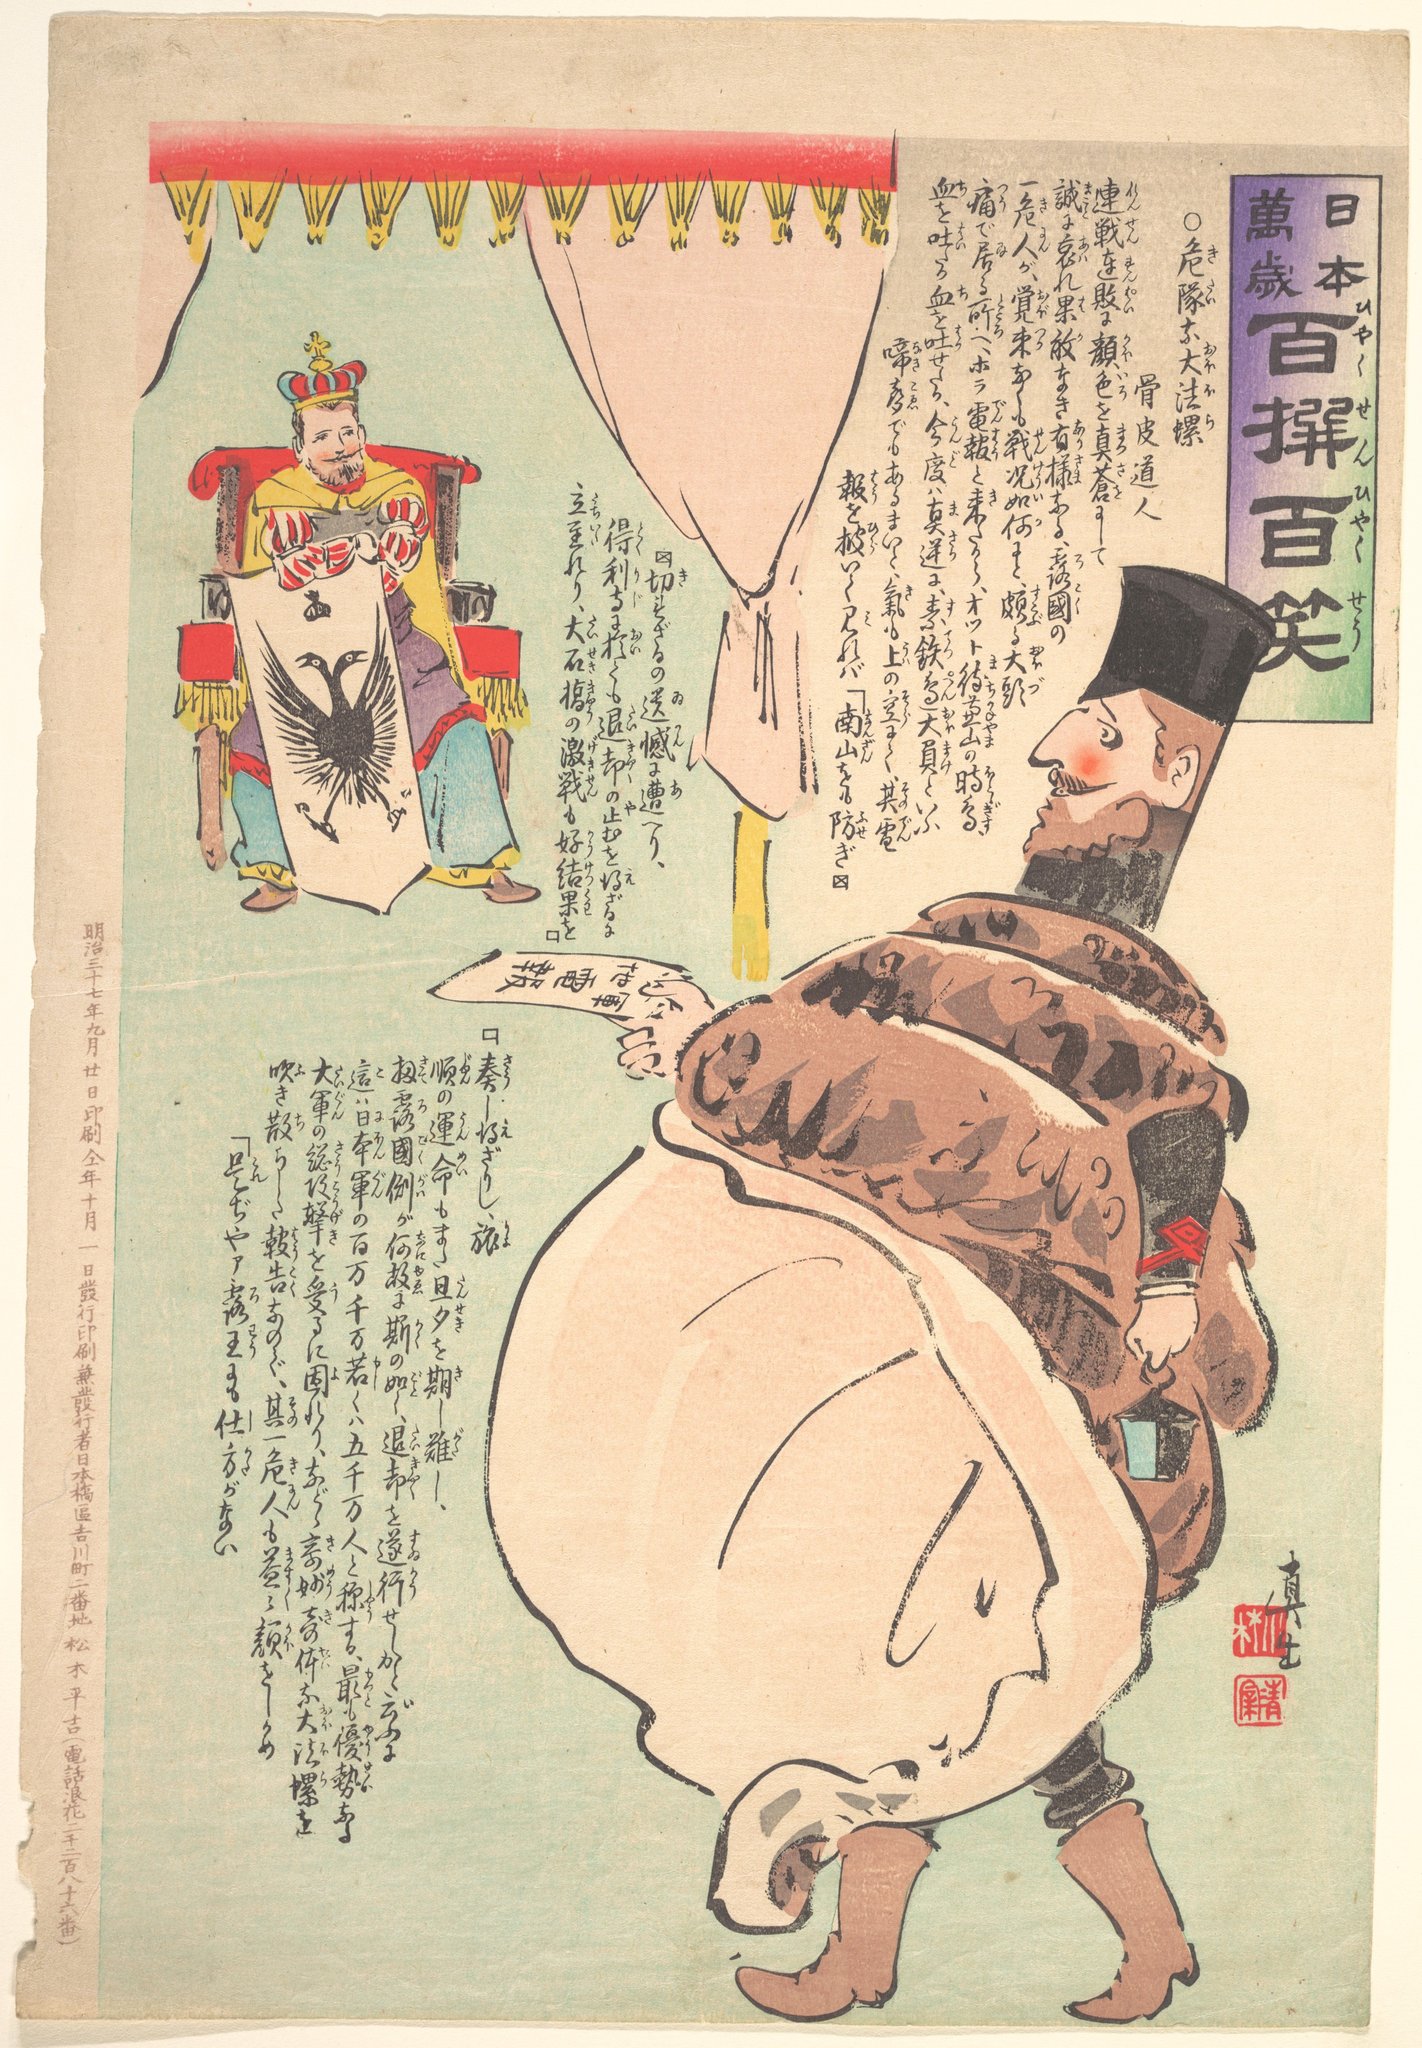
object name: print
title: Print from the series Long Live Japan: One Hundred Victories, One Hundred Laughs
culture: japanese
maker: kobayashi kiyochika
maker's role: artist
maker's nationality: japanese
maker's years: 1847-1915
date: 1904-1905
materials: ink, paper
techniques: nishiki e, woodblock print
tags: kings,men,law